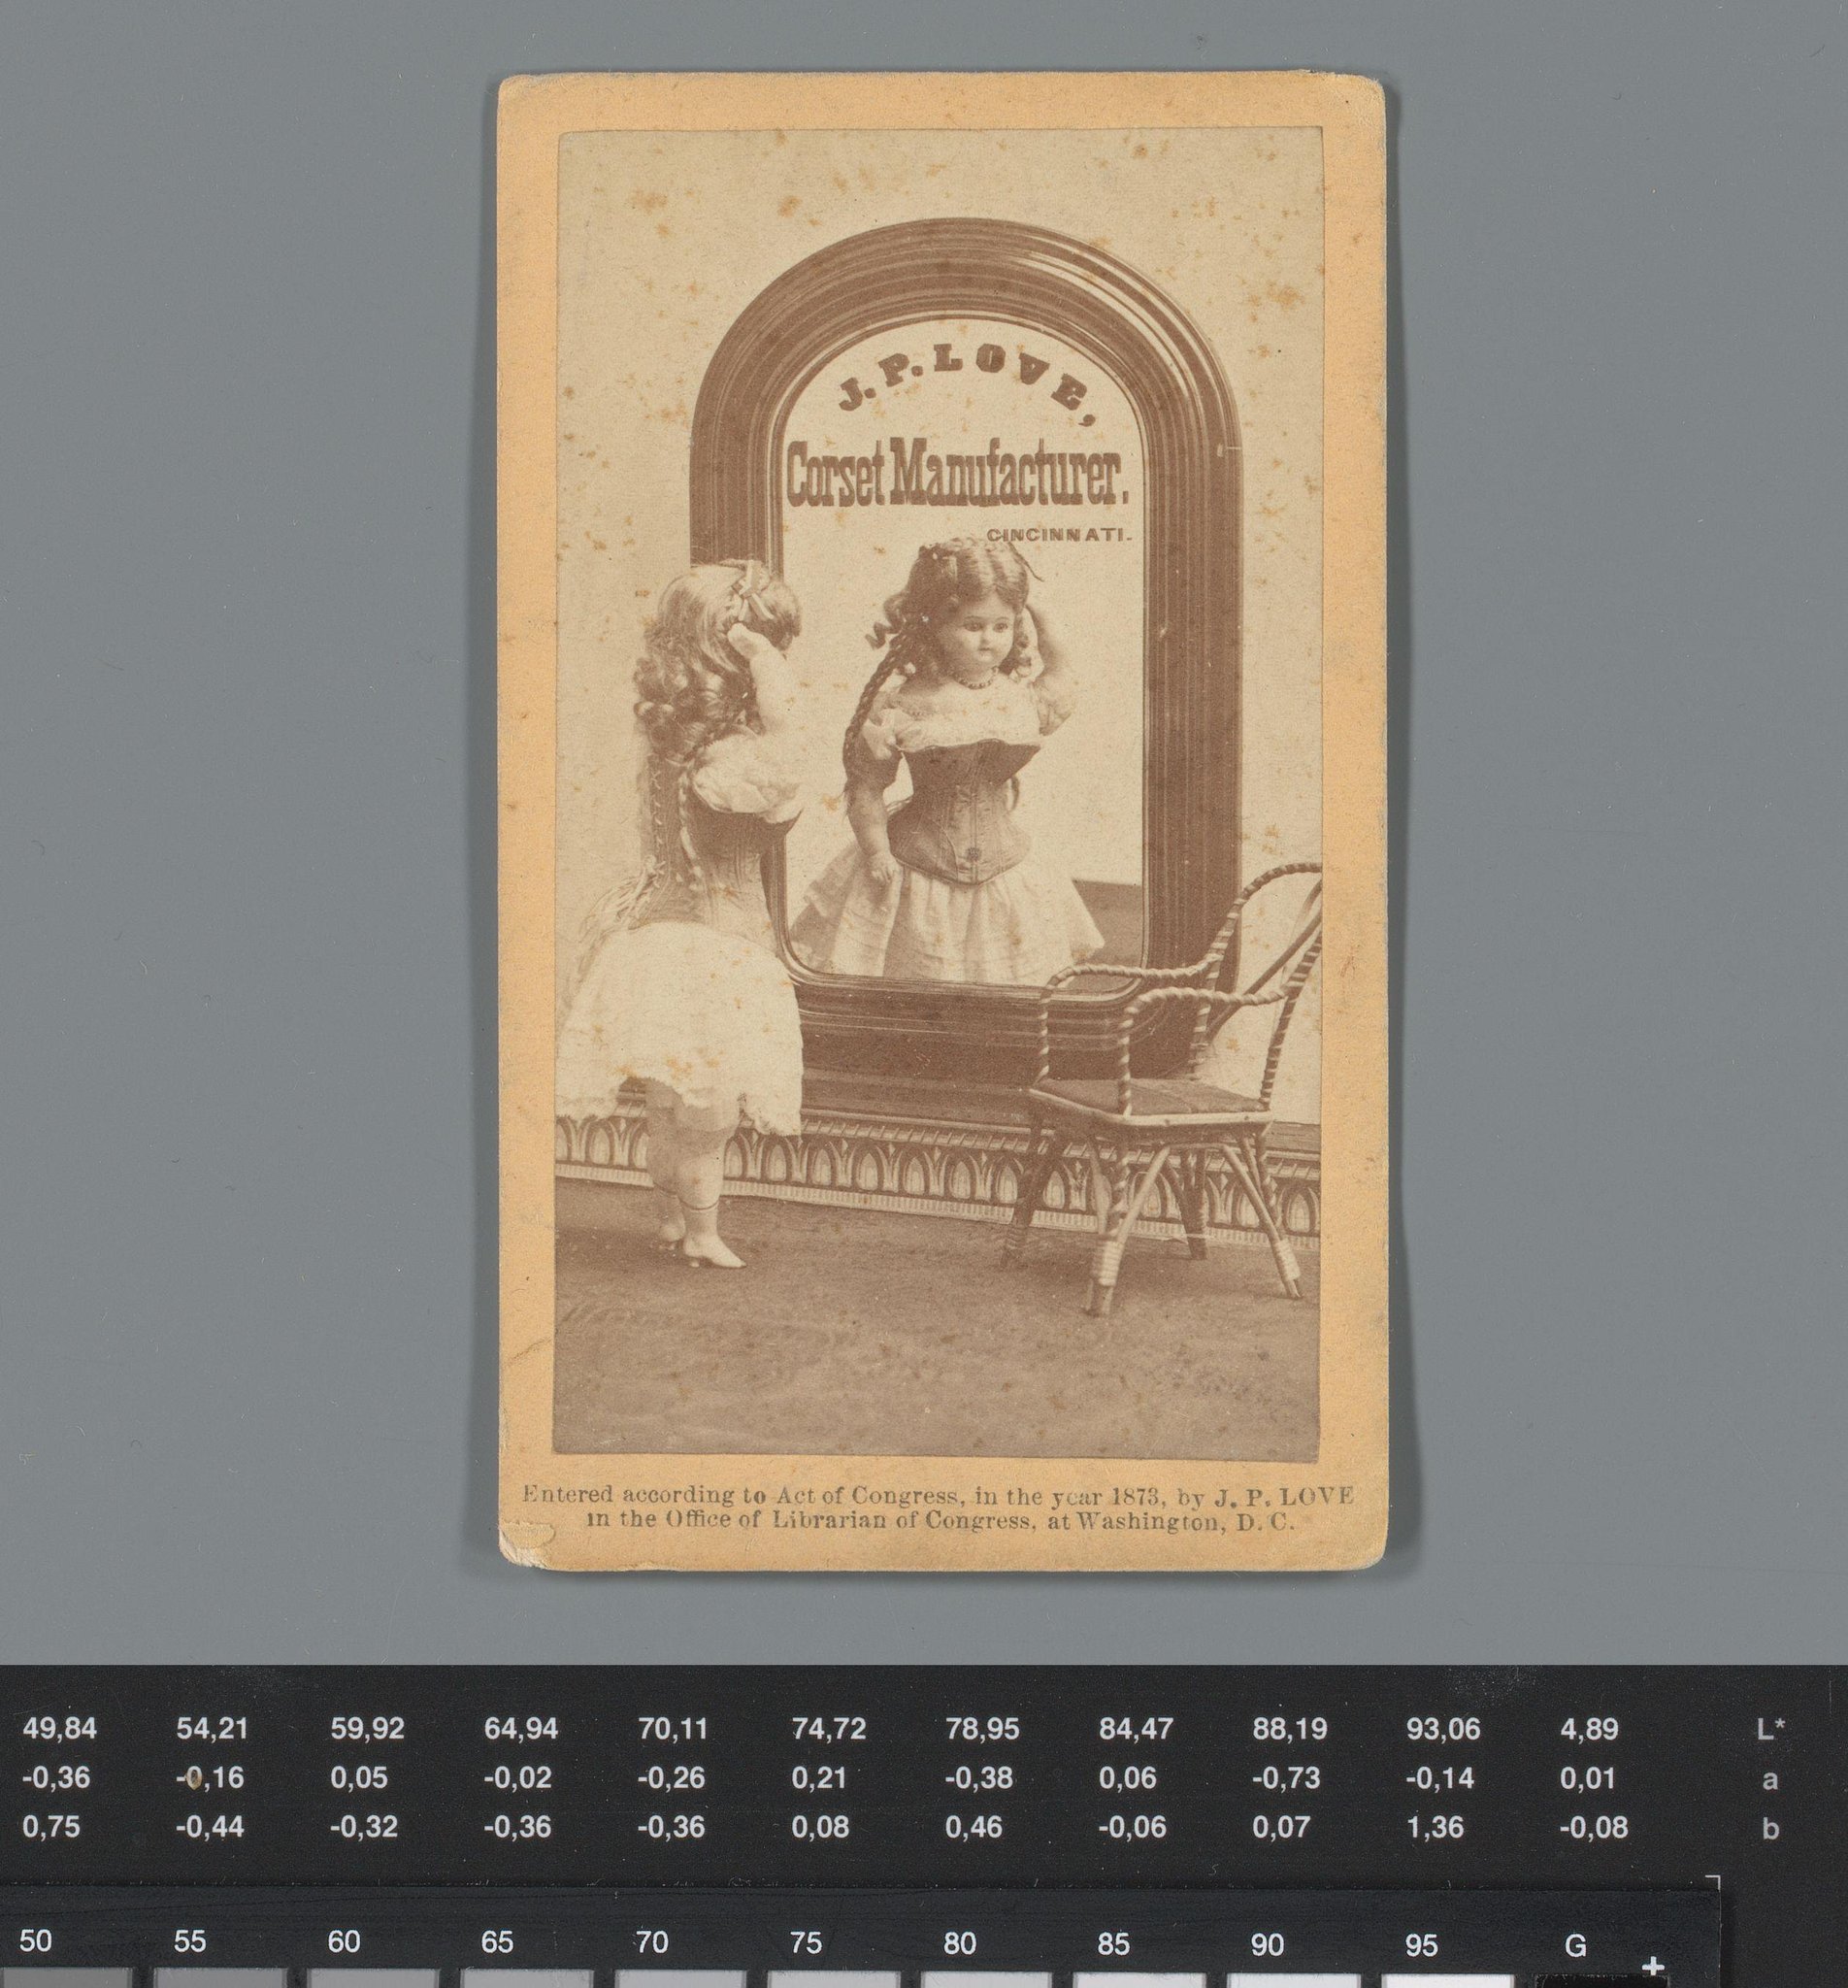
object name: carte de visite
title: Reclame voor korsetten van J.P. Love te Cincinnati met gezicht op een pop in een korset voor een spiegel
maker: Anonymous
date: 1850-1915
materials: cardboard, photographic support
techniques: albumen print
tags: advertising, doll's clothes, underclothes for the upper part of the body: corset, reflection (in a mirror)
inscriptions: inscription: ‘J.P. LOVE, / Manufacturer of and Dealer in / CORSETS ! (...) CINCINNATI, O.’